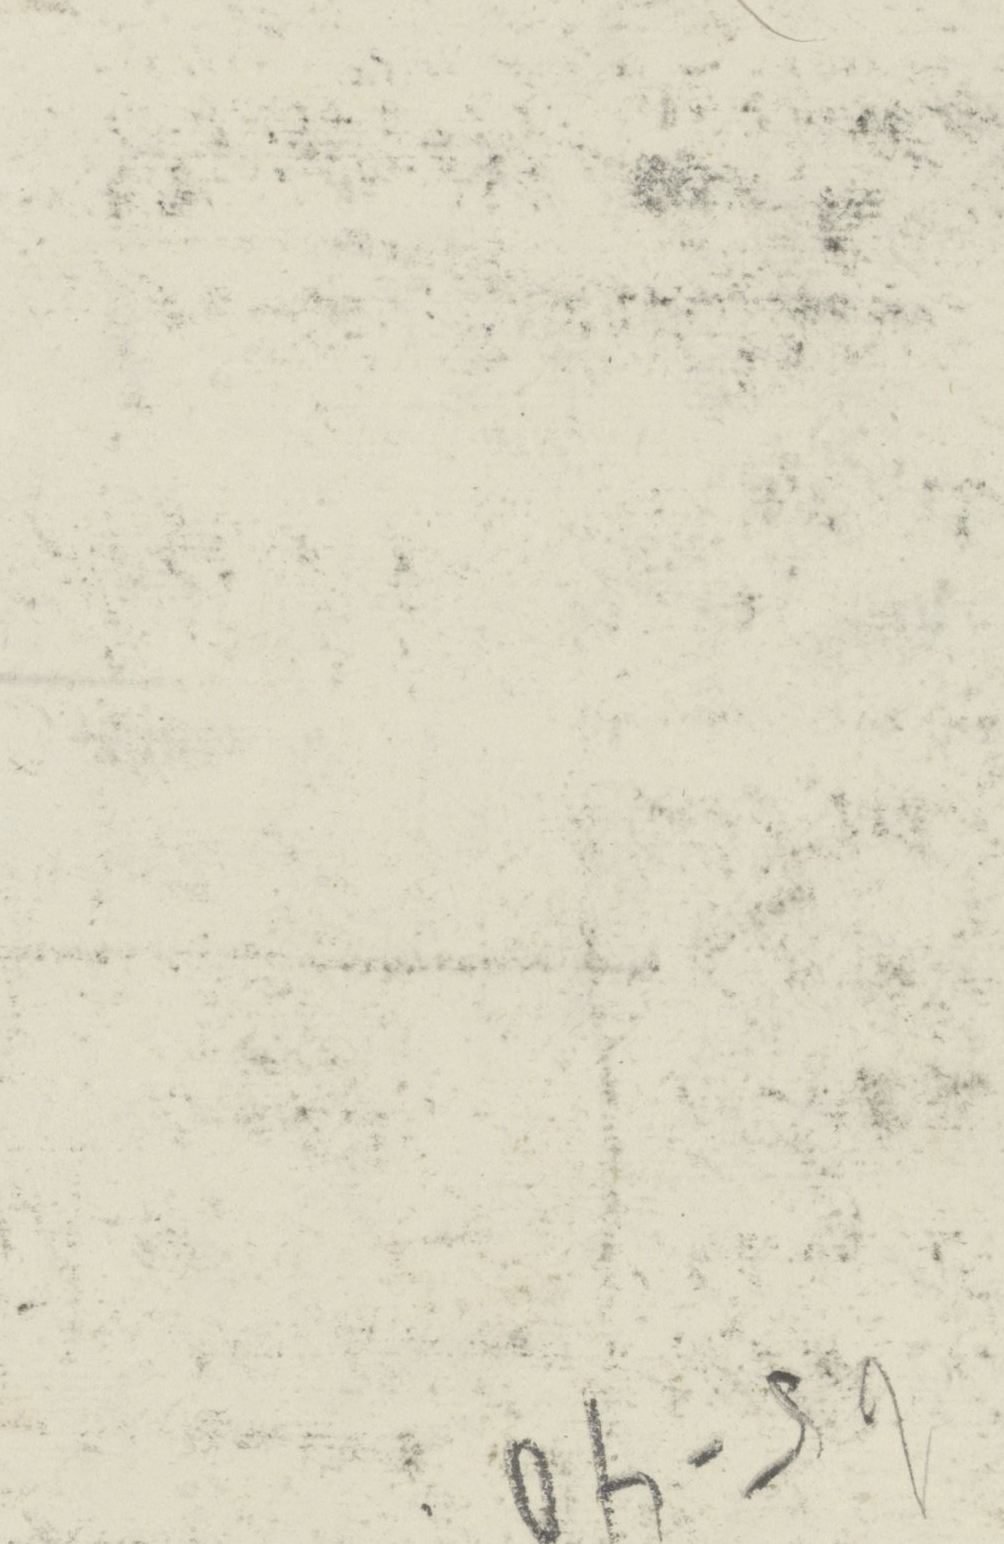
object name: sketchbook leaf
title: Annotatie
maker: george hendrik breitner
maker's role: draughtsman, painter, print maker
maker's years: 1857-1923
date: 1887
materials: chalk, paper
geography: amsterdam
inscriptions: annotation: ‘[...]’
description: Pagina 28, achterste schutblad, uit een schetsboek met 12 bladen.